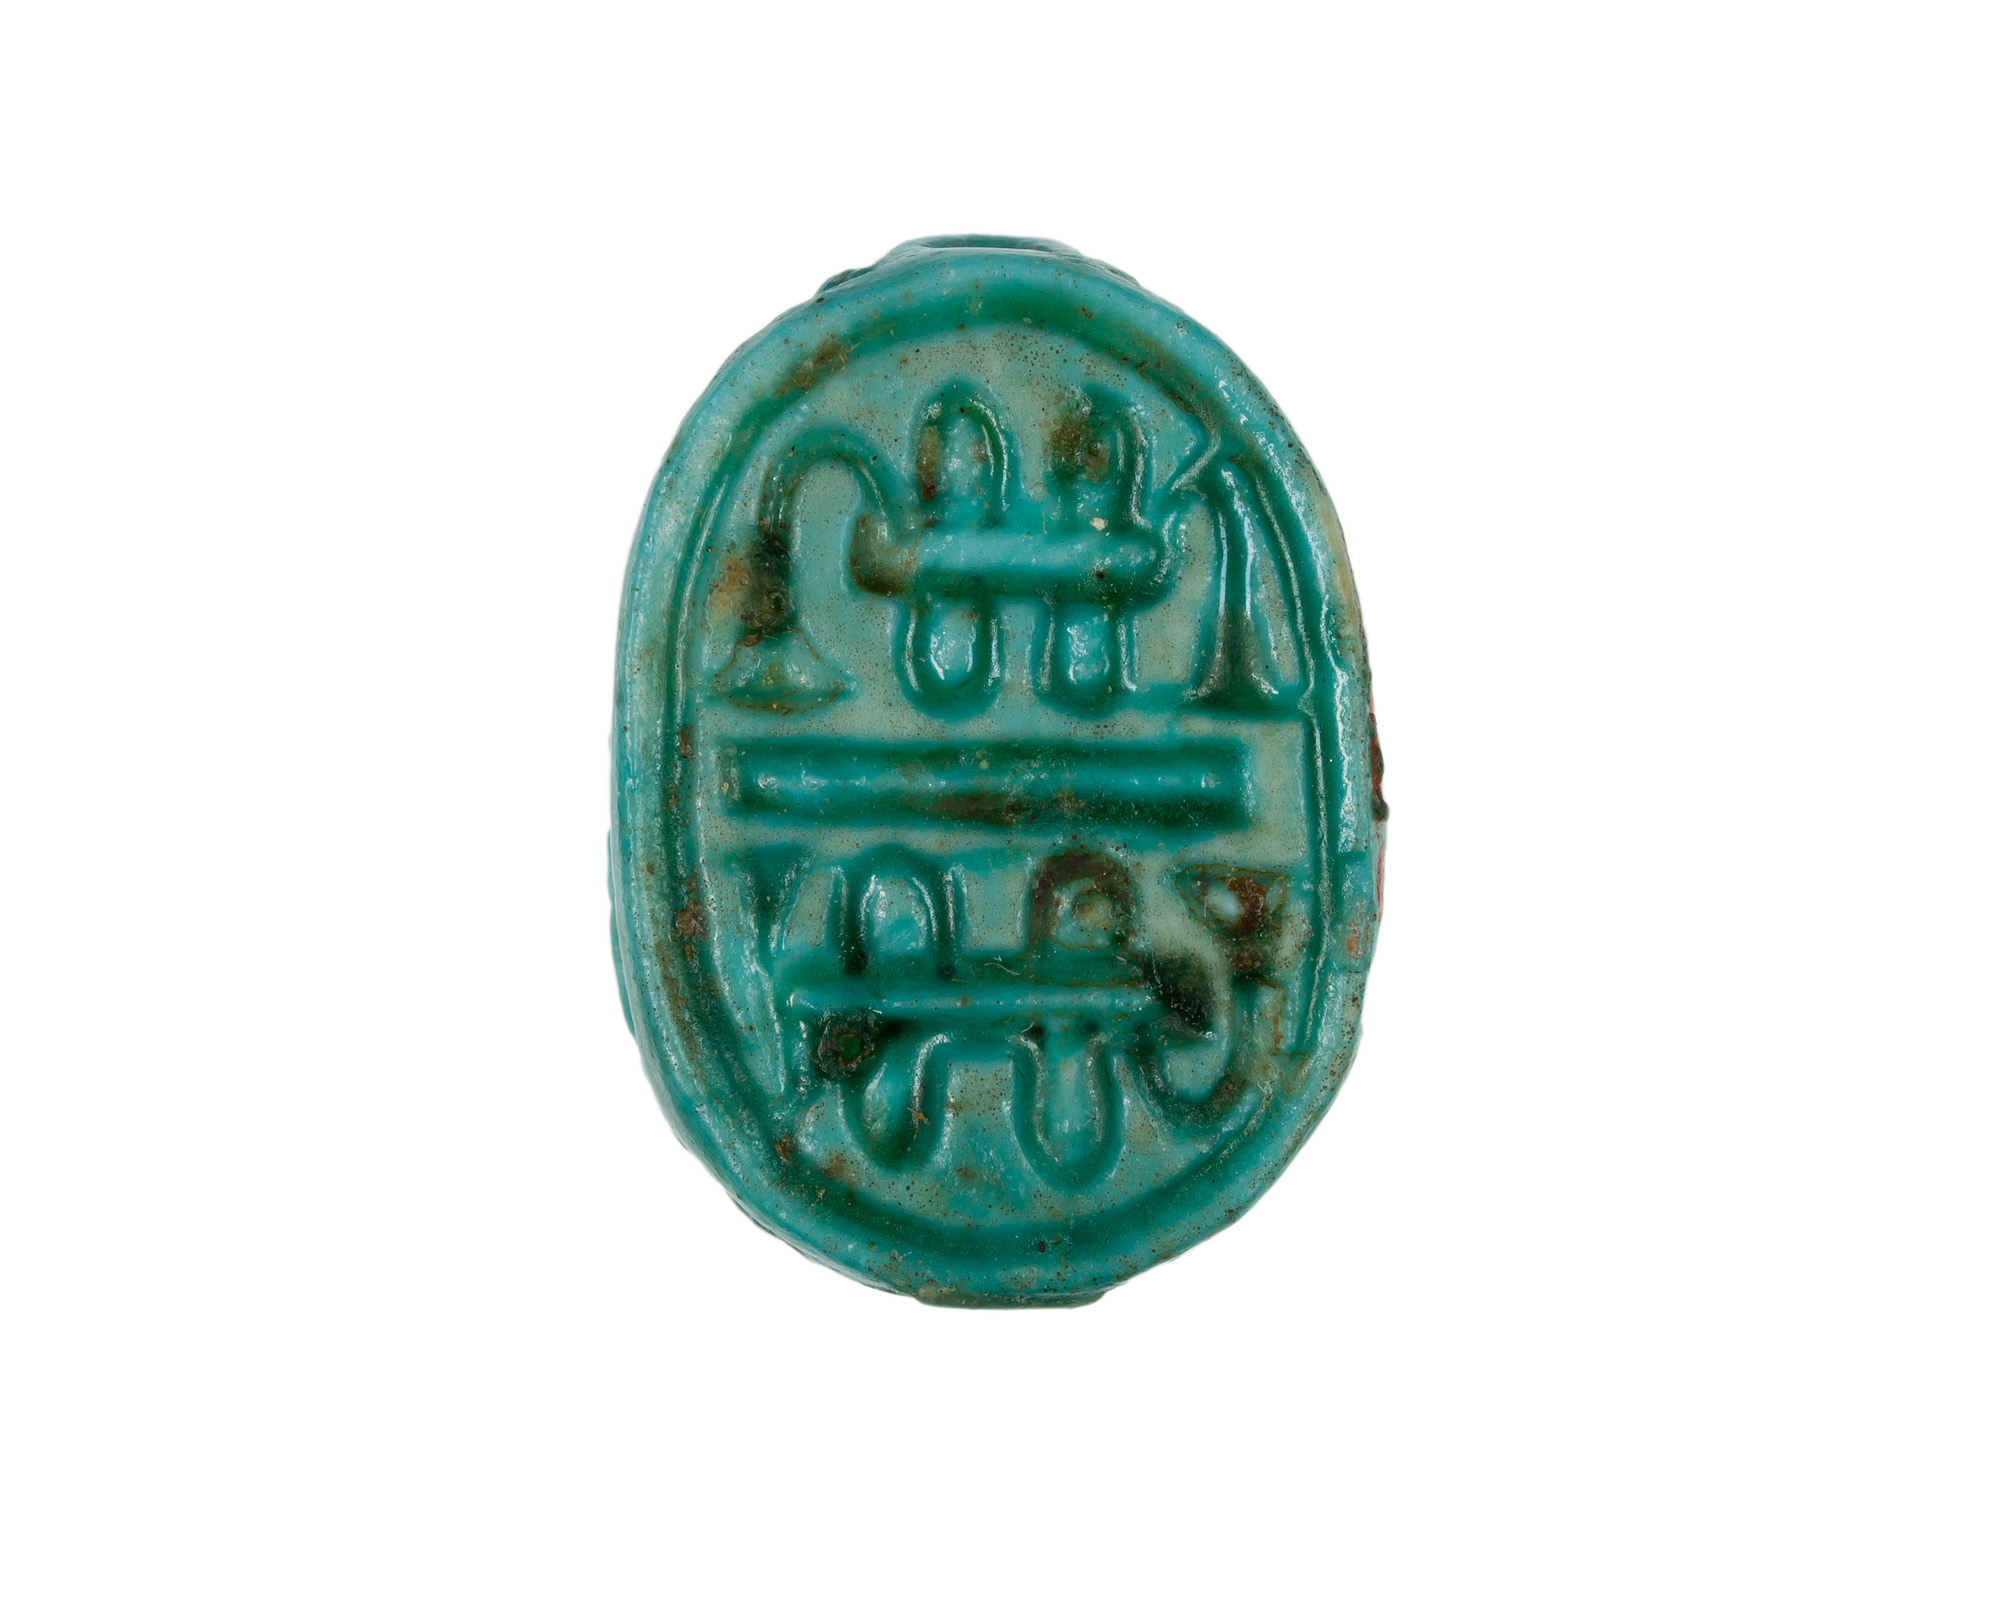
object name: scarab, private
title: Scarab with decorative motif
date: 1550-1295 BCE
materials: faience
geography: egypt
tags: scarabs